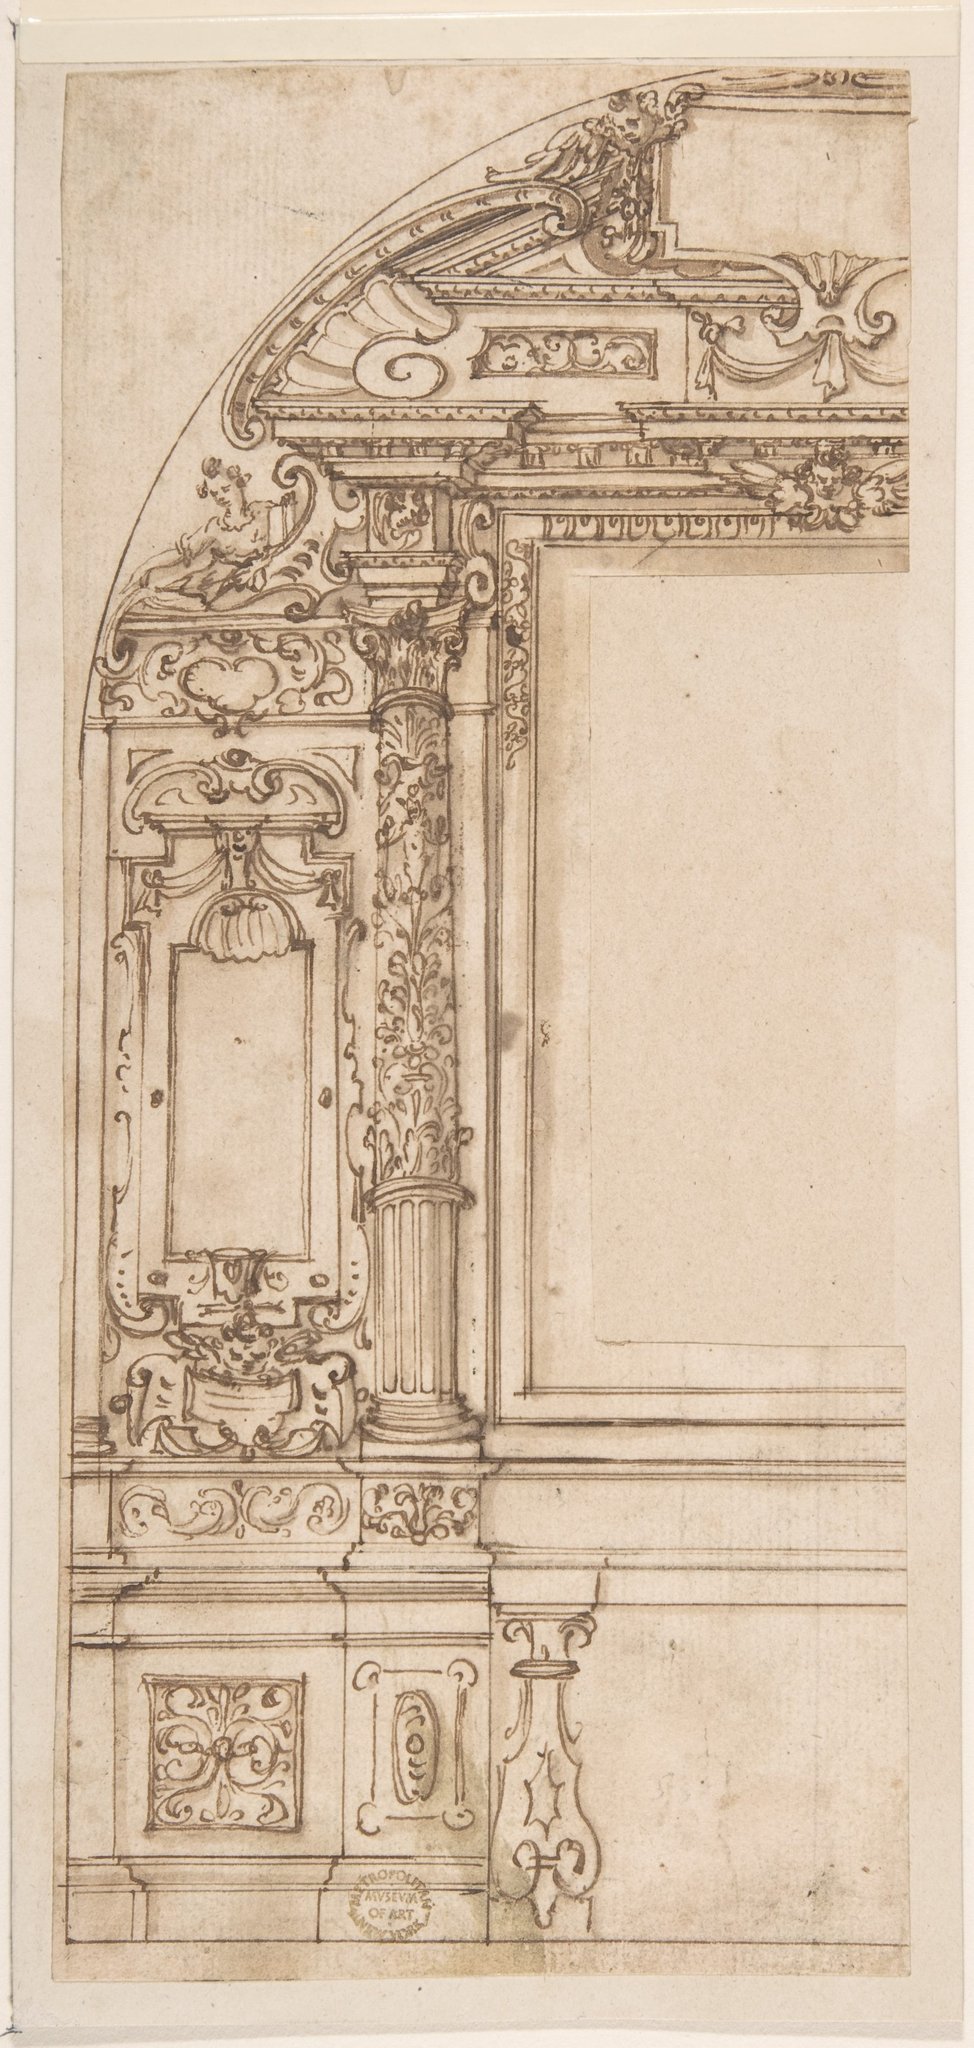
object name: drawing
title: Design for an Altar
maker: anonymous, italian, roman-bolognese, 17th century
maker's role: artist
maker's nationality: italian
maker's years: 1600-1700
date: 1601-1700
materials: chalk, ink, paper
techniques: brush, pen, wash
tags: ornament